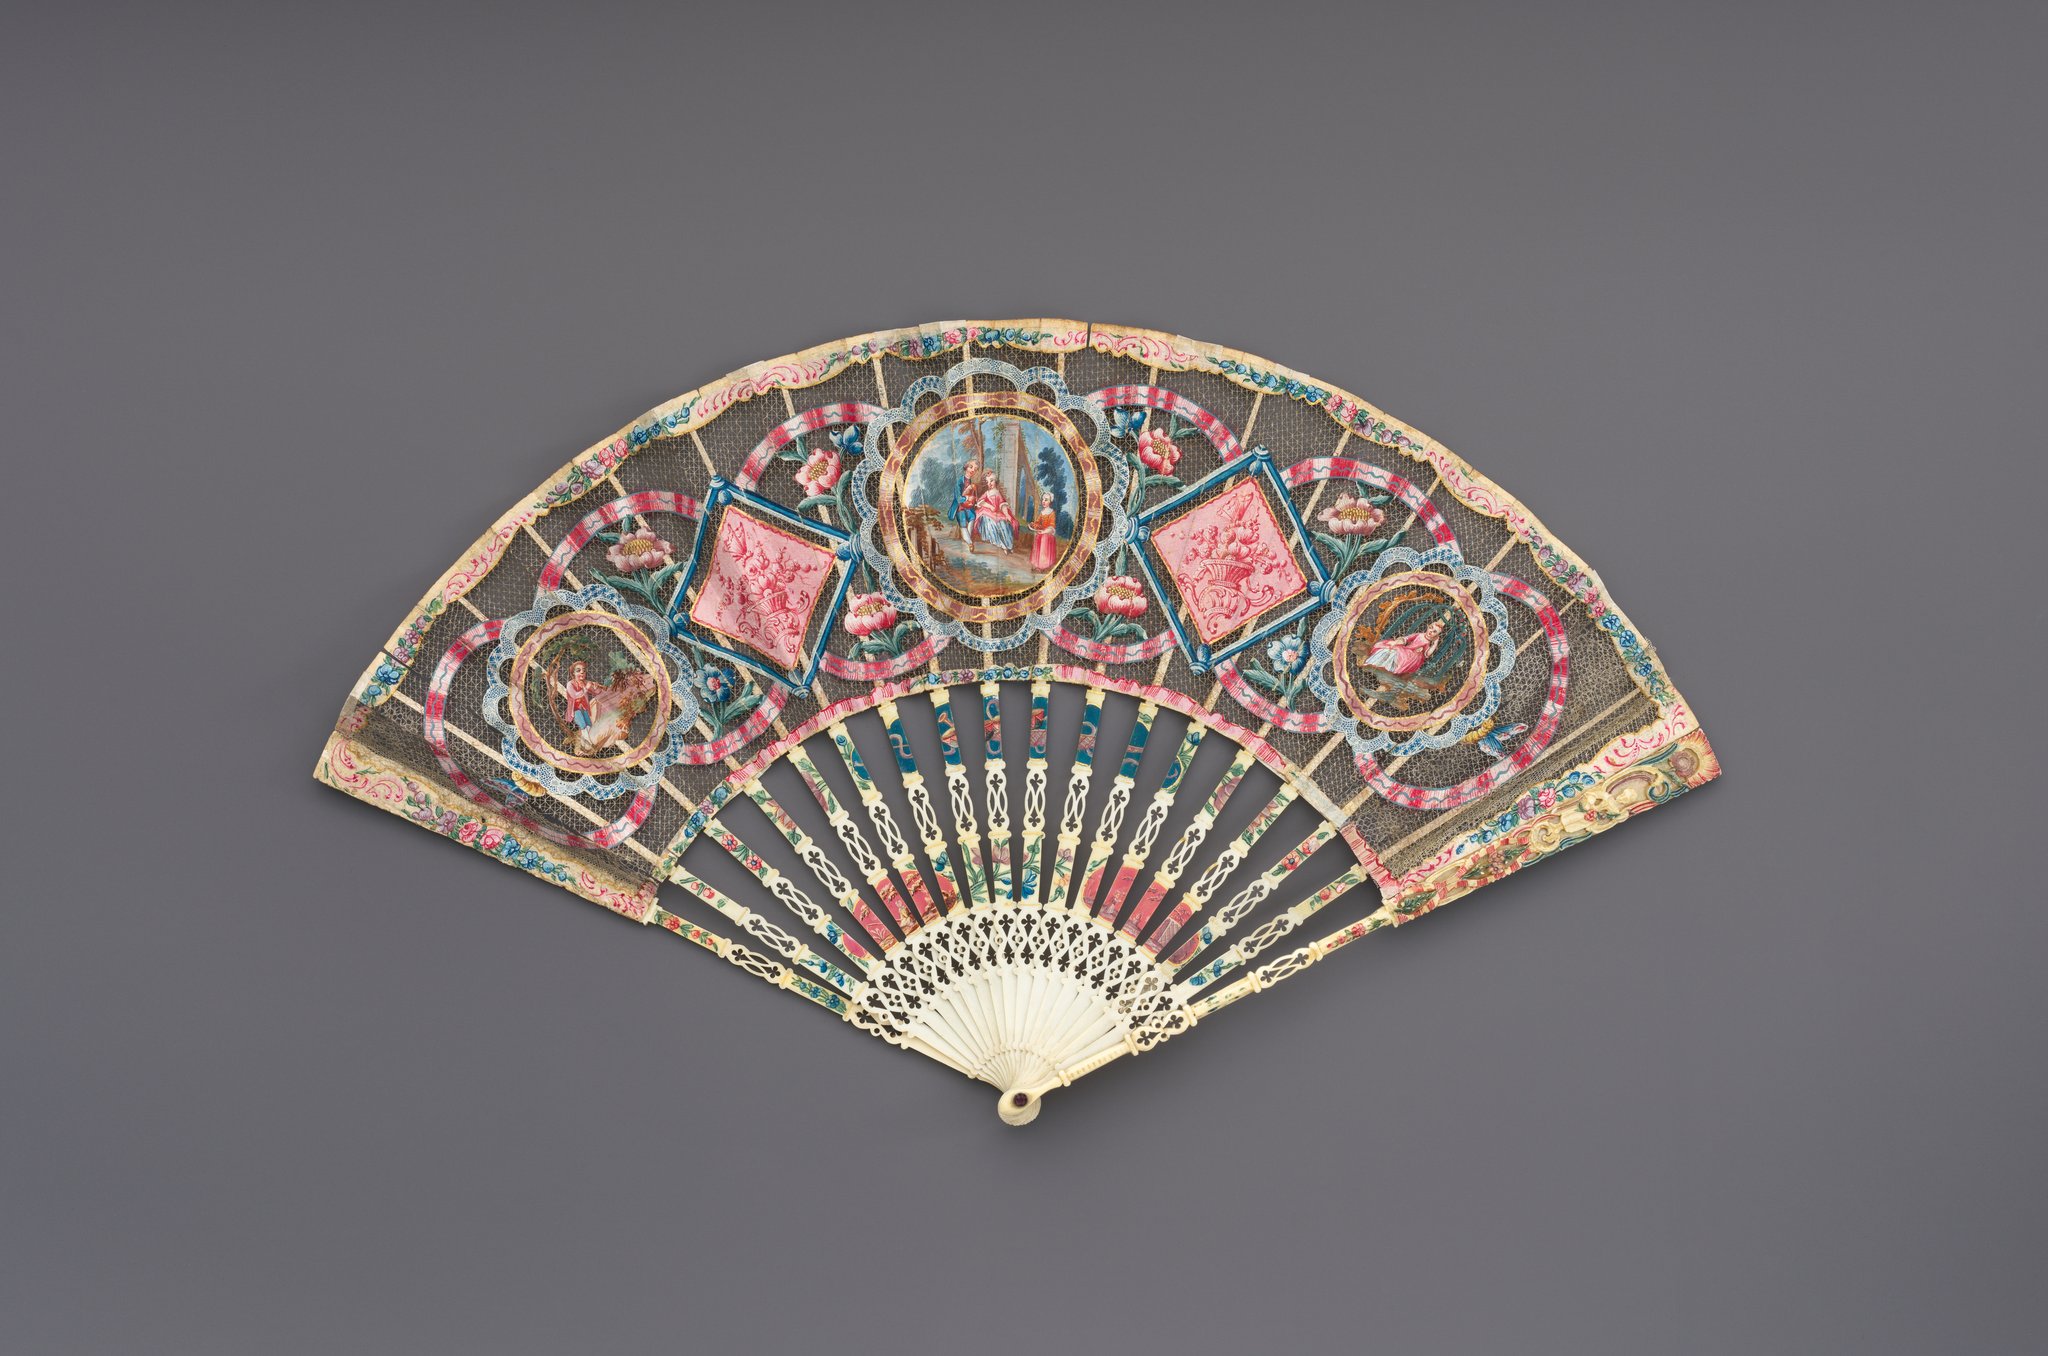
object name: fan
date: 1774-1793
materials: ivory, paint, paper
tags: men,women